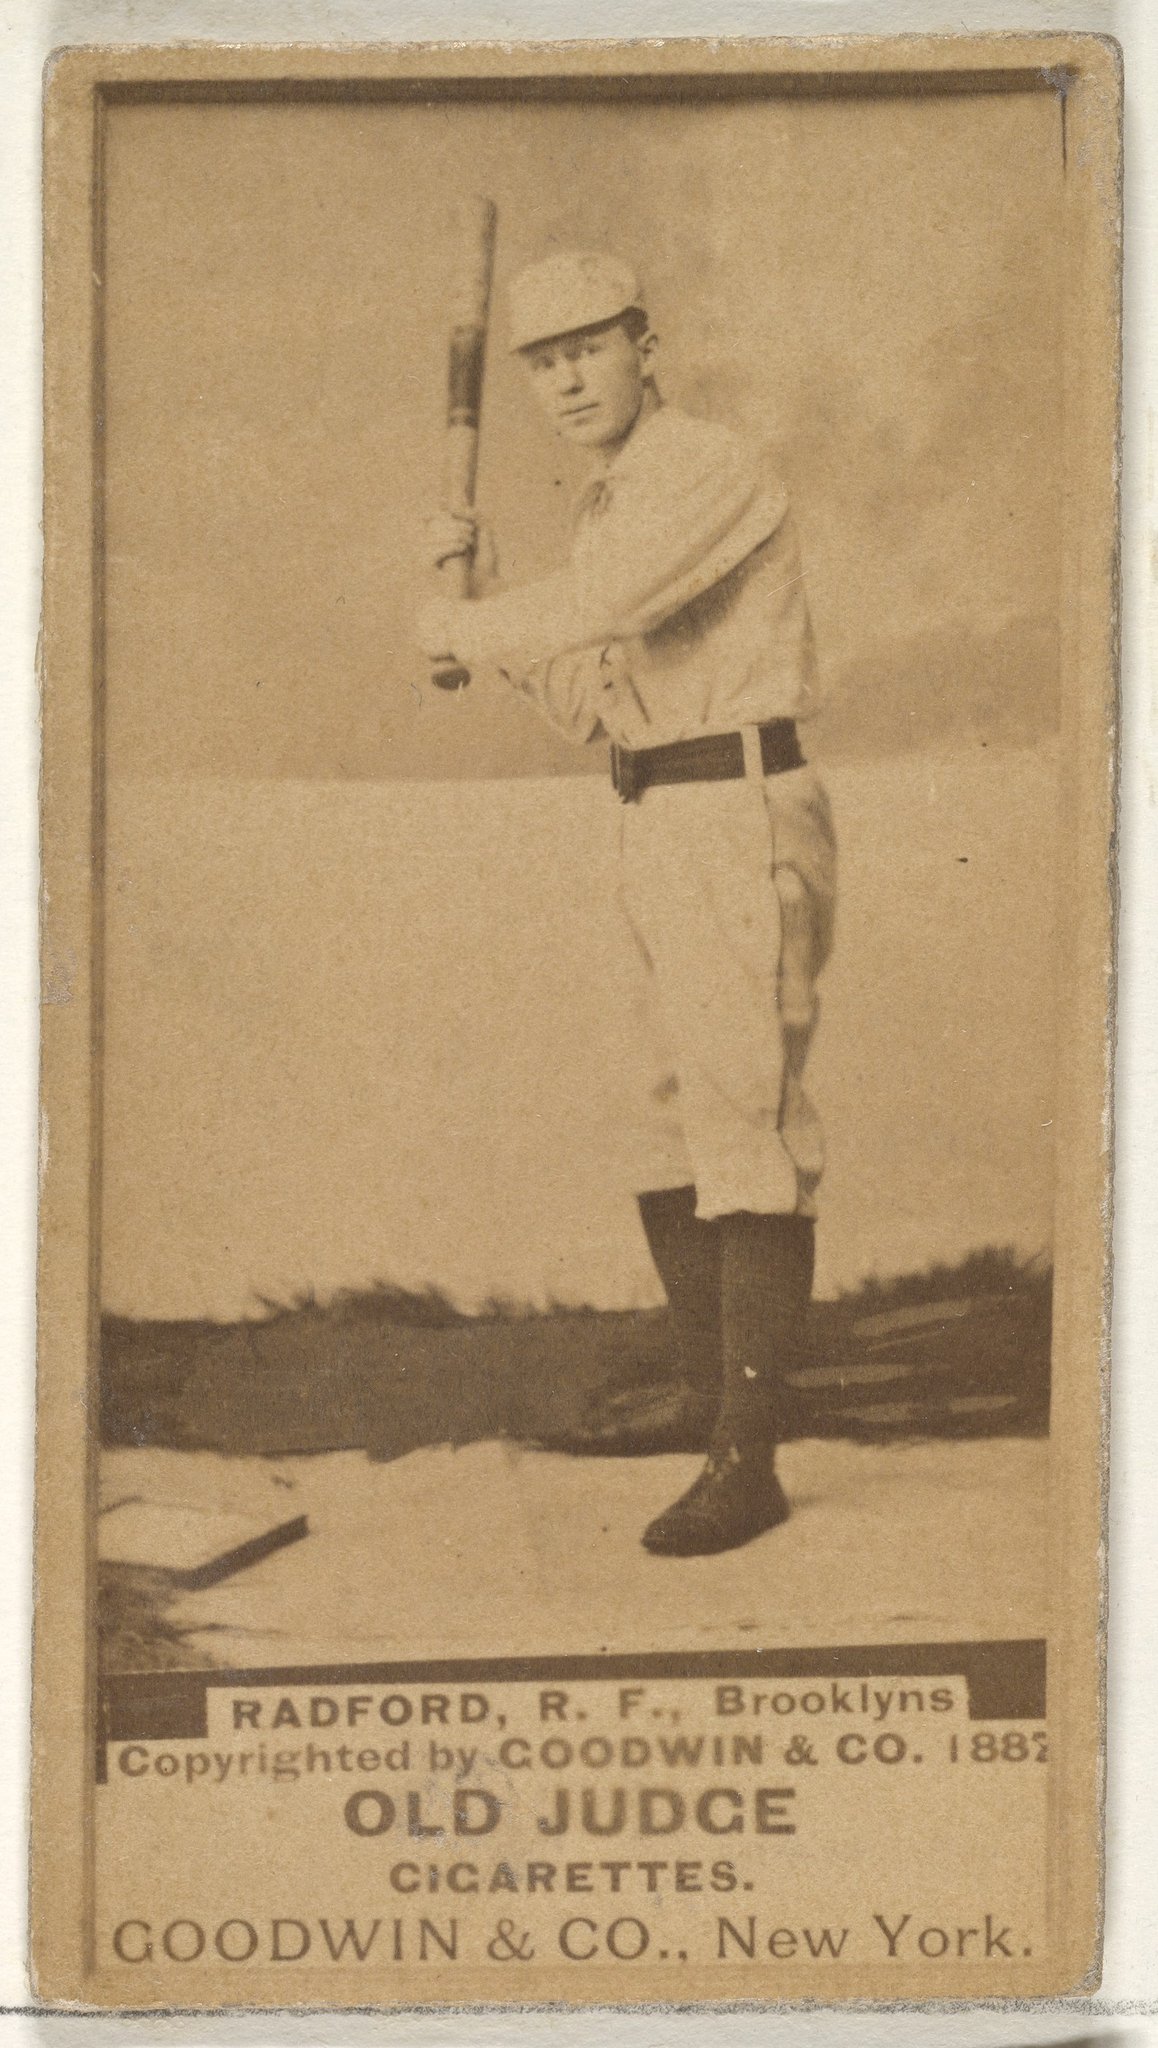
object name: baseball card, photograph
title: Radford, Right Field, Brooklyn Bridegrooms, from the Old Judge series (N172) for Old Judge Cigarettes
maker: goodwin & company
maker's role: publisher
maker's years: 1850-1950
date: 1888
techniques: albumen silver print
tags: men,portraits,baseball,athletes